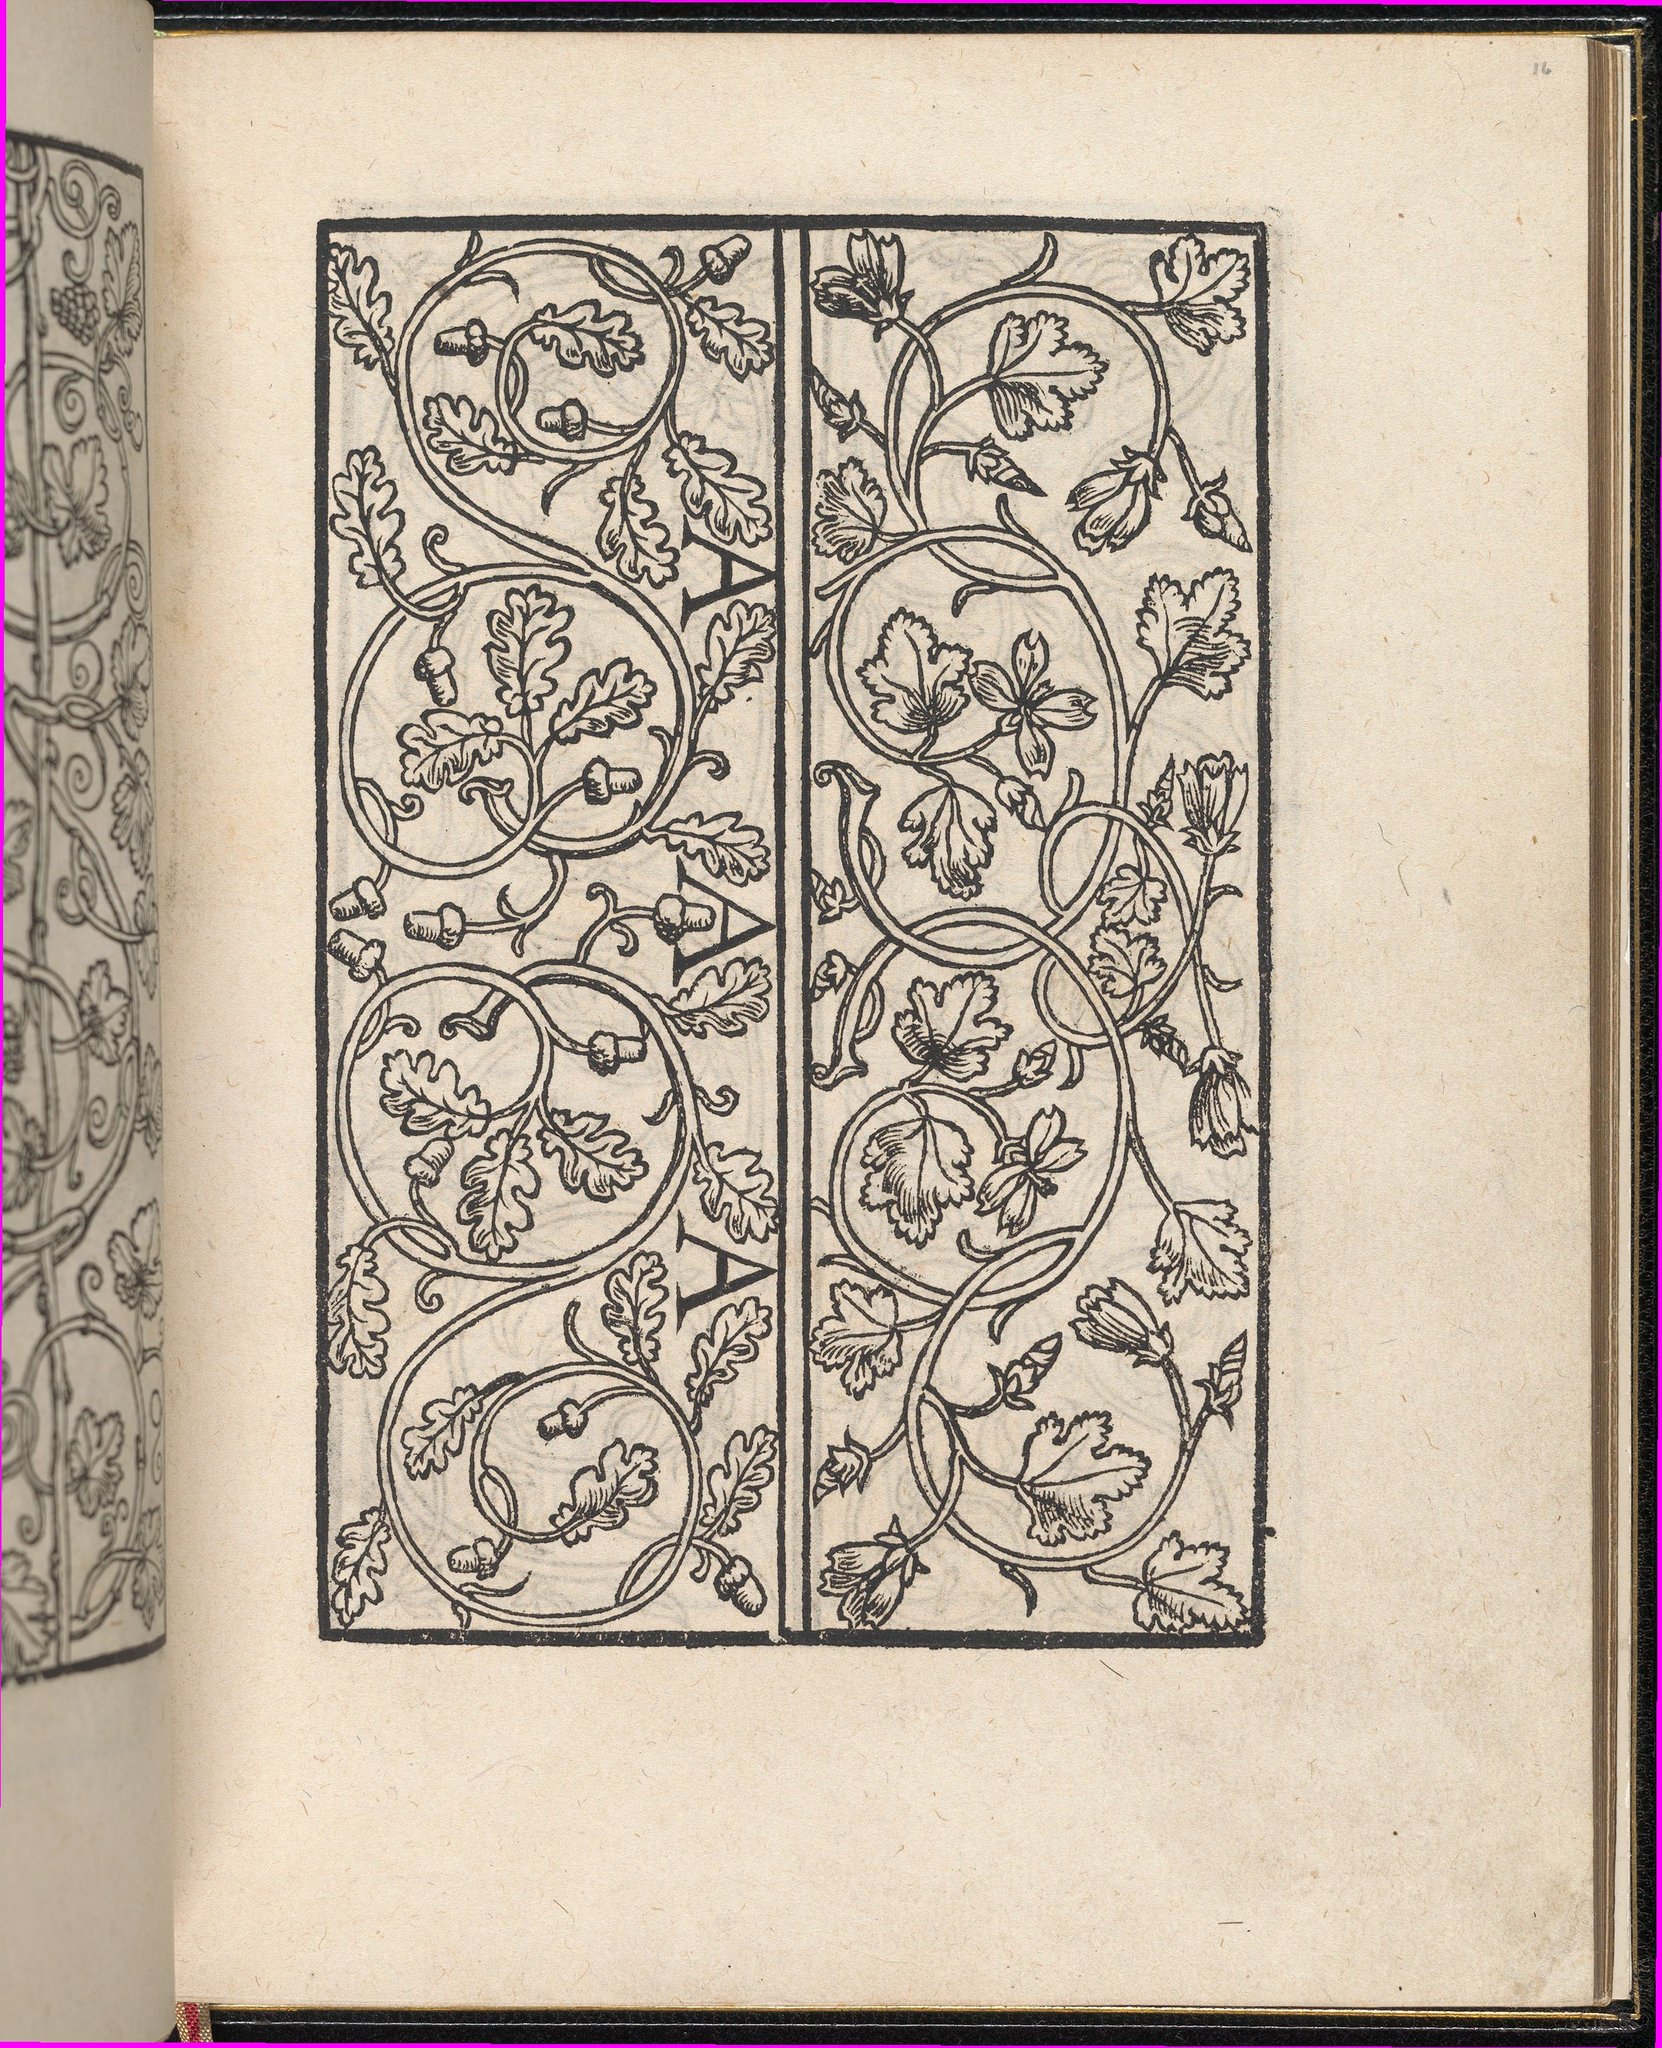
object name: book print ornament architecture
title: Page from Ein new kunstlich Modelbuch...(Page 16r)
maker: peter quentel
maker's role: publisher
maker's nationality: german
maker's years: 1500-1550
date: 1544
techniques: woodcut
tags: flowers